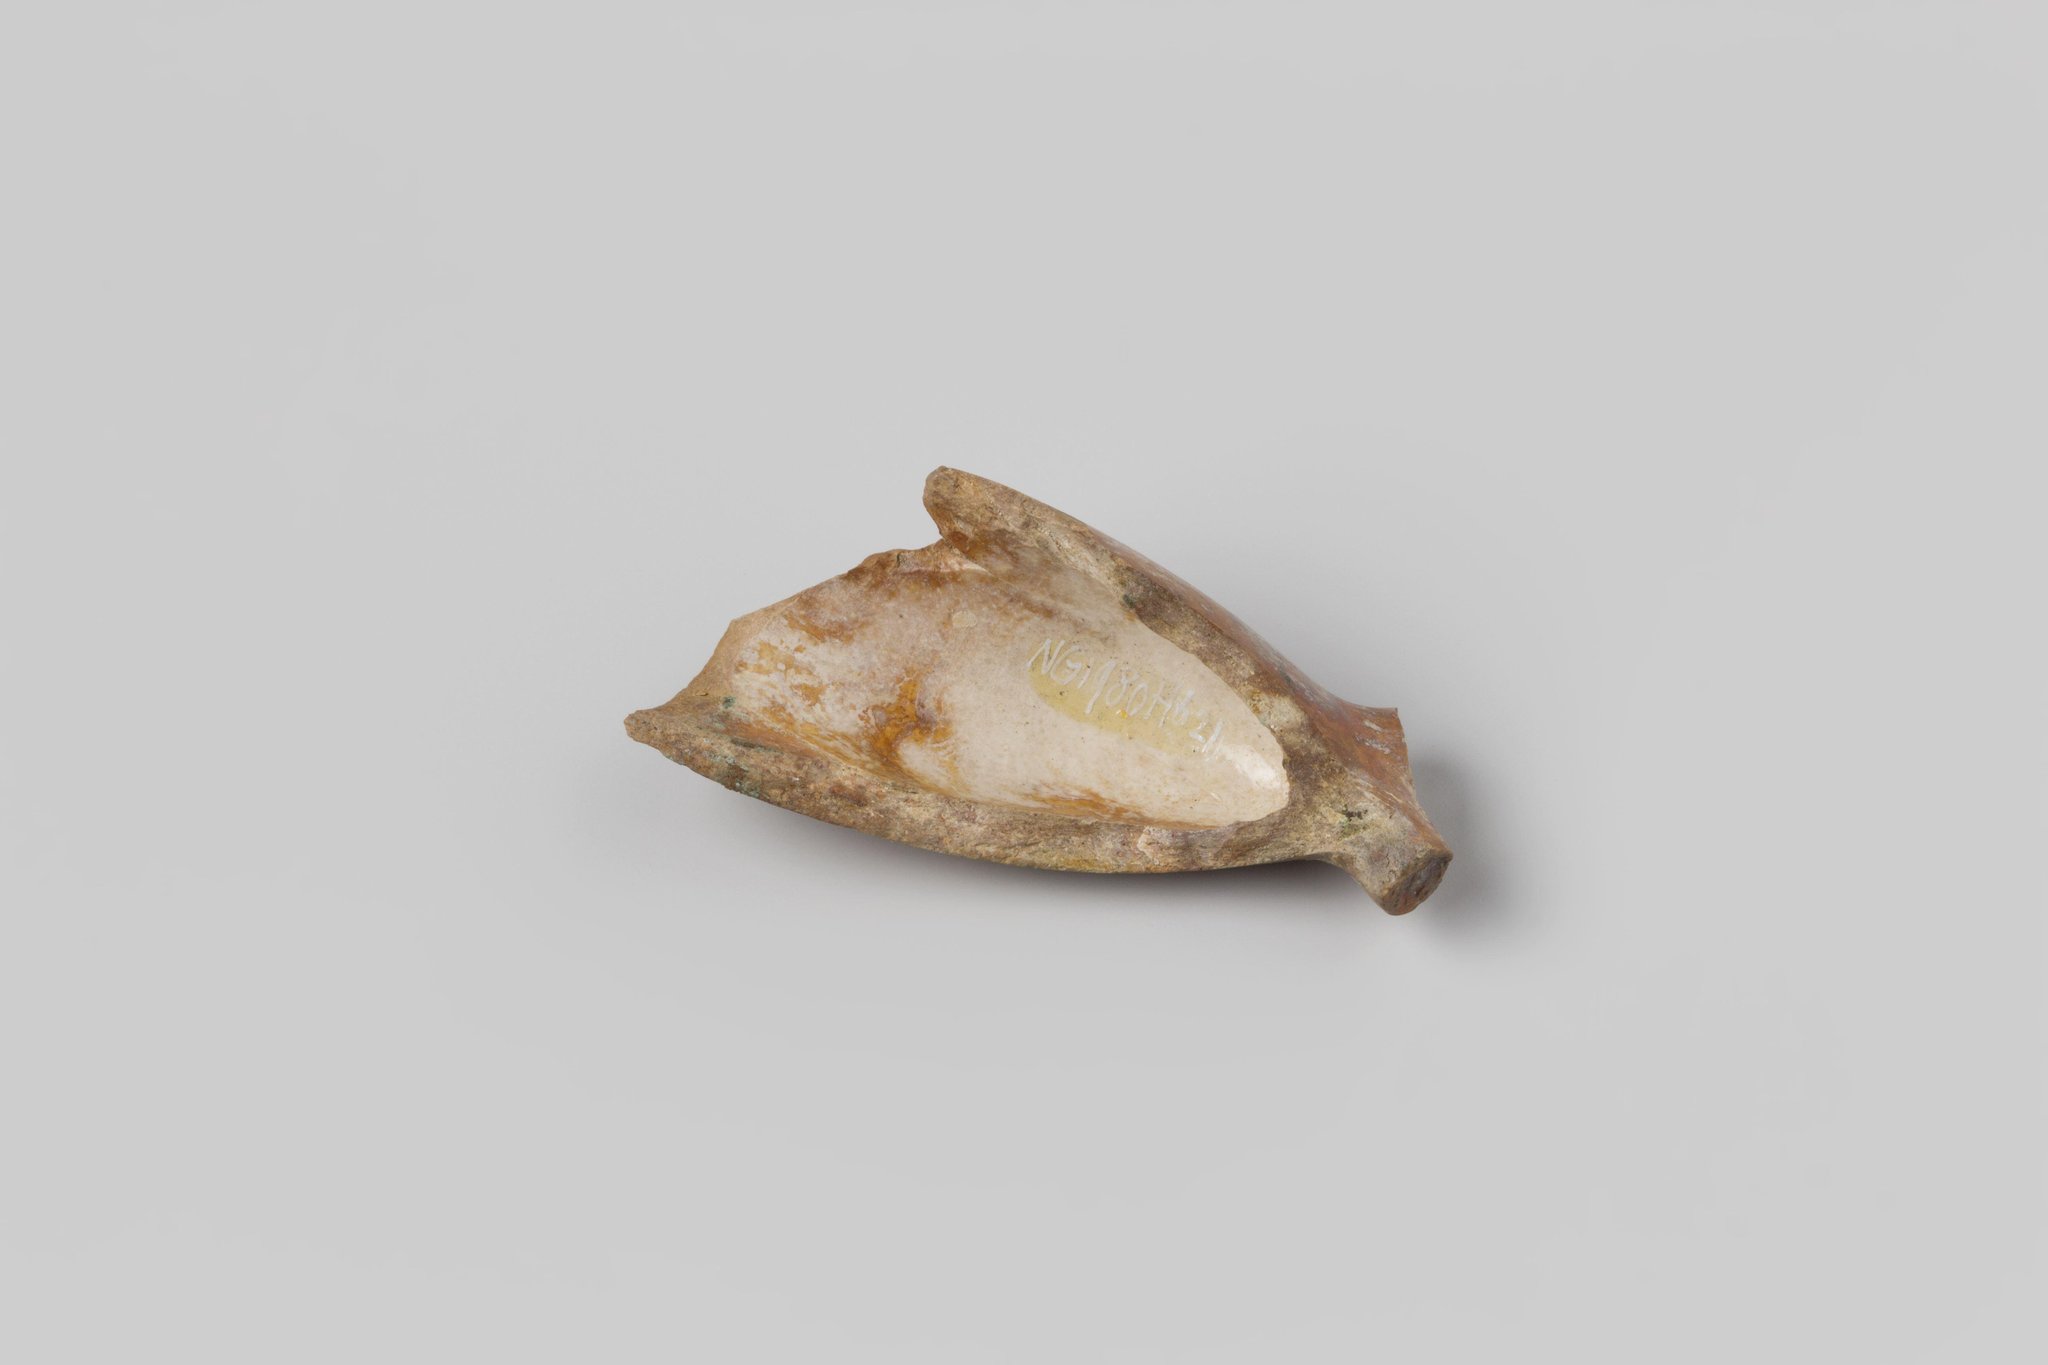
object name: pipe bowl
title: Fragment pijpenkop uit het wrak van de Oost-Indiëvaarder Hollandia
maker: Anonymous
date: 1700-1743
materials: clay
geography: netherlands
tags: verenigde oostindische compagnie, hollandia (schip), annet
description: Pipe, bowl, heelmark: crowned 57; fragment, no hsm.